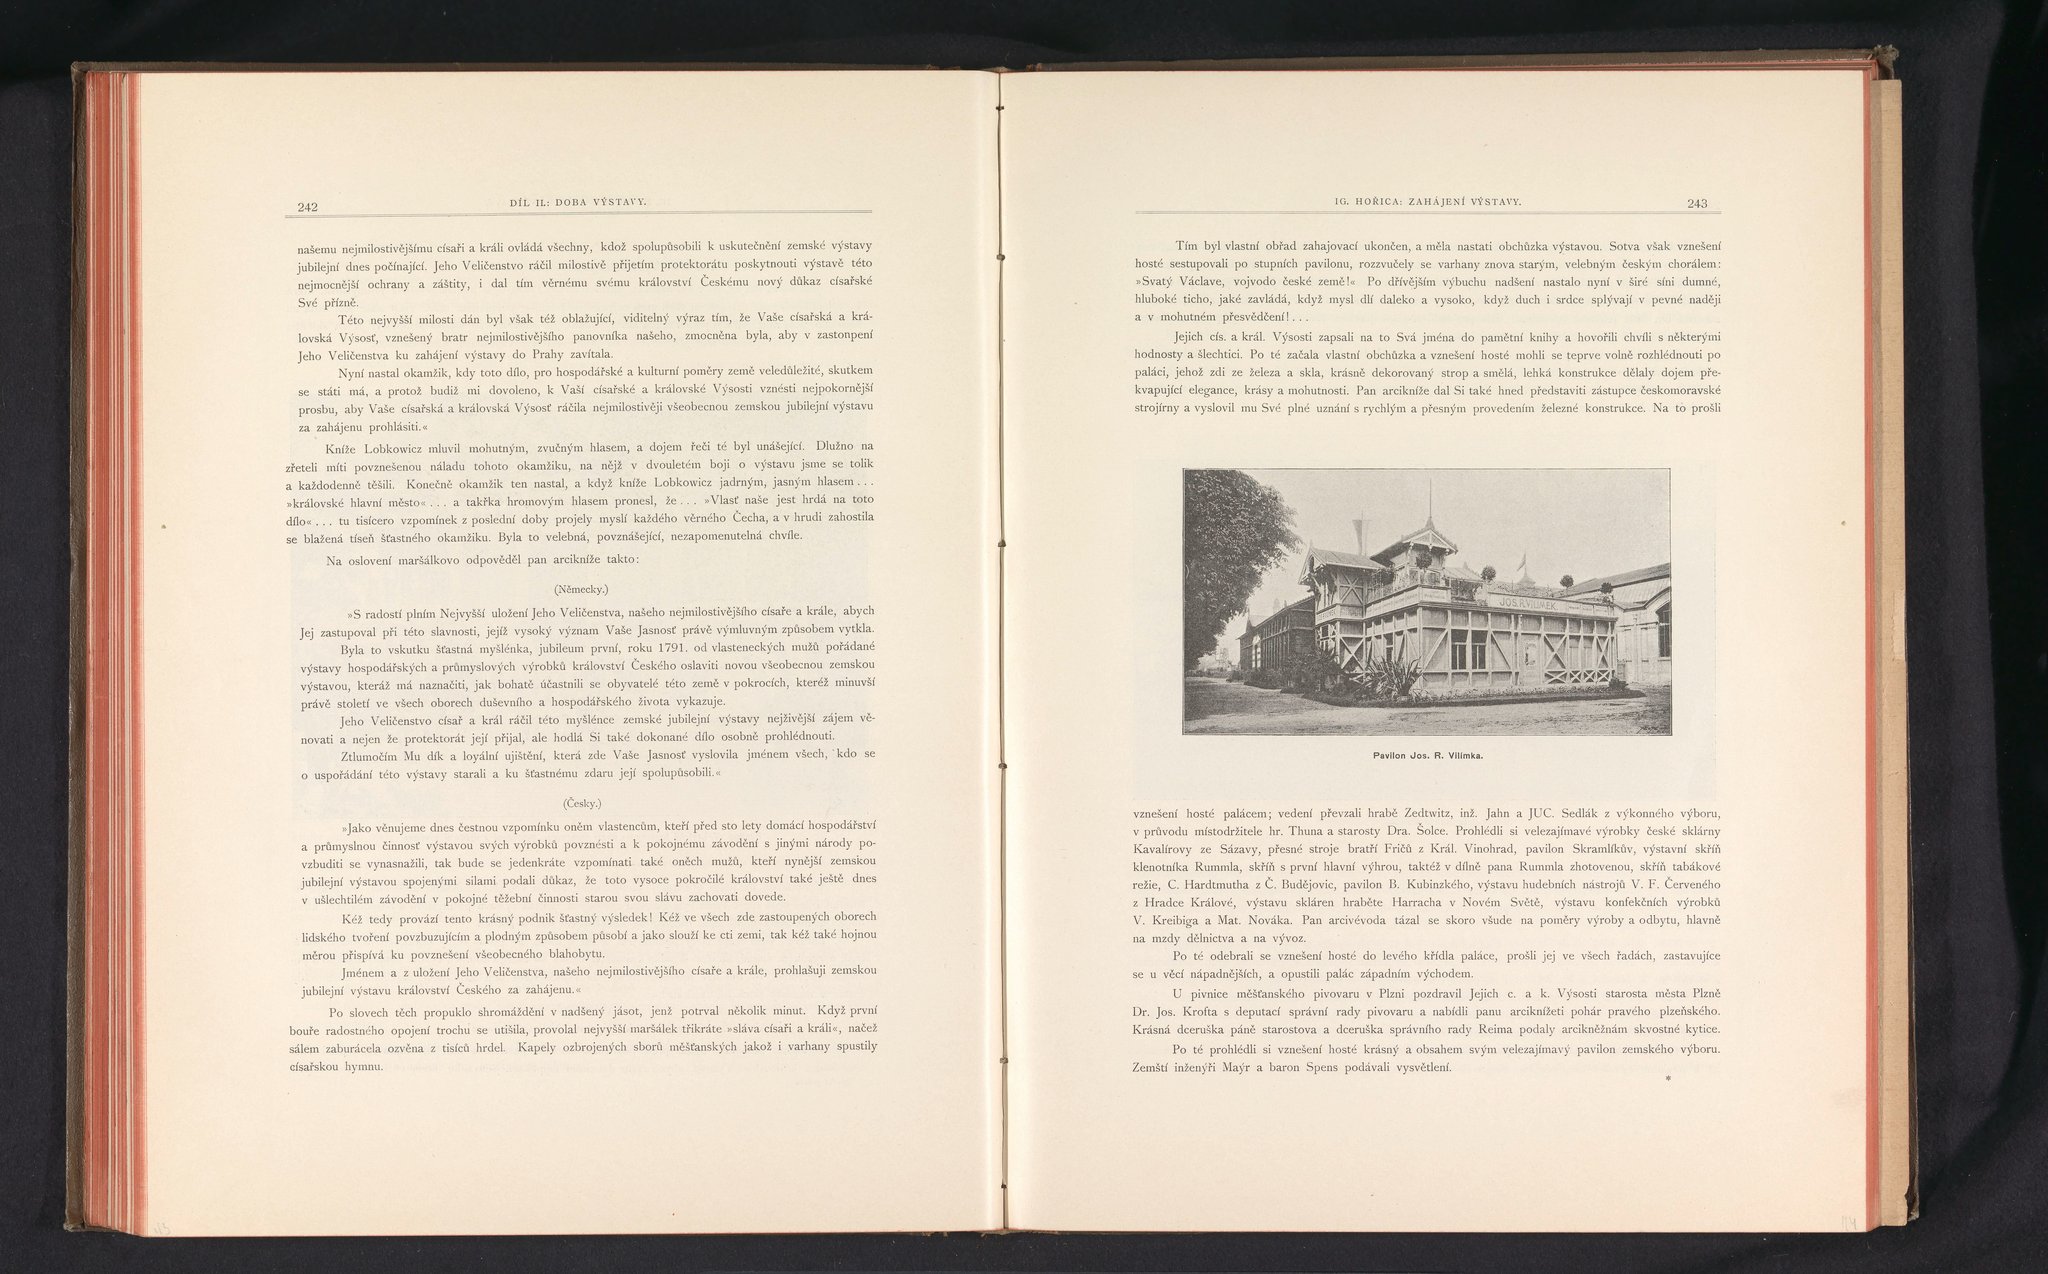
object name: page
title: Exterieur van een paviljoen op het Výstaviště te Praag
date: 1891-1893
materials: paper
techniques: autotype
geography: prague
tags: façade (of house or building), anonymous historical persons portrayed in a group, in a group-portrait